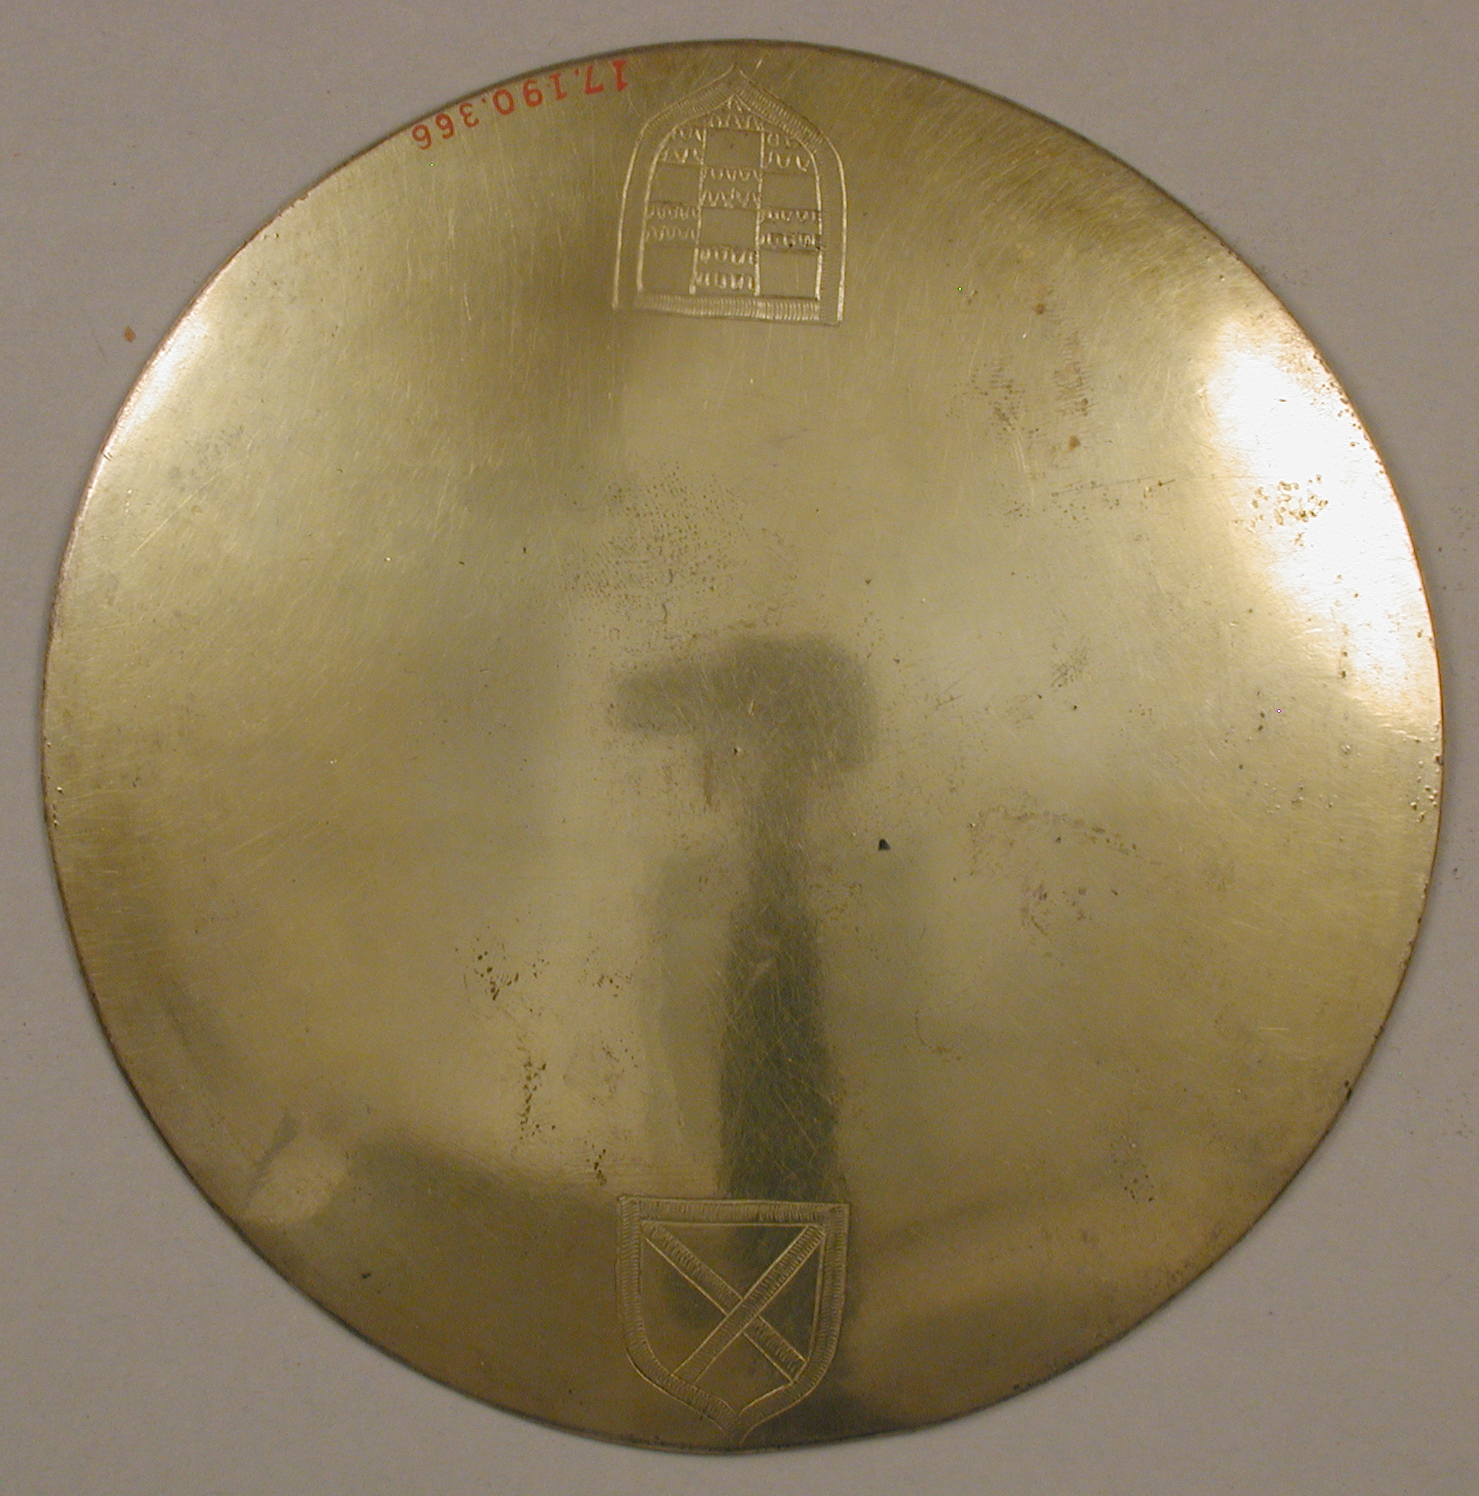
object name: paten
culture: spanish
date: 1450-1500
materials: silver gilt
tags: insignia